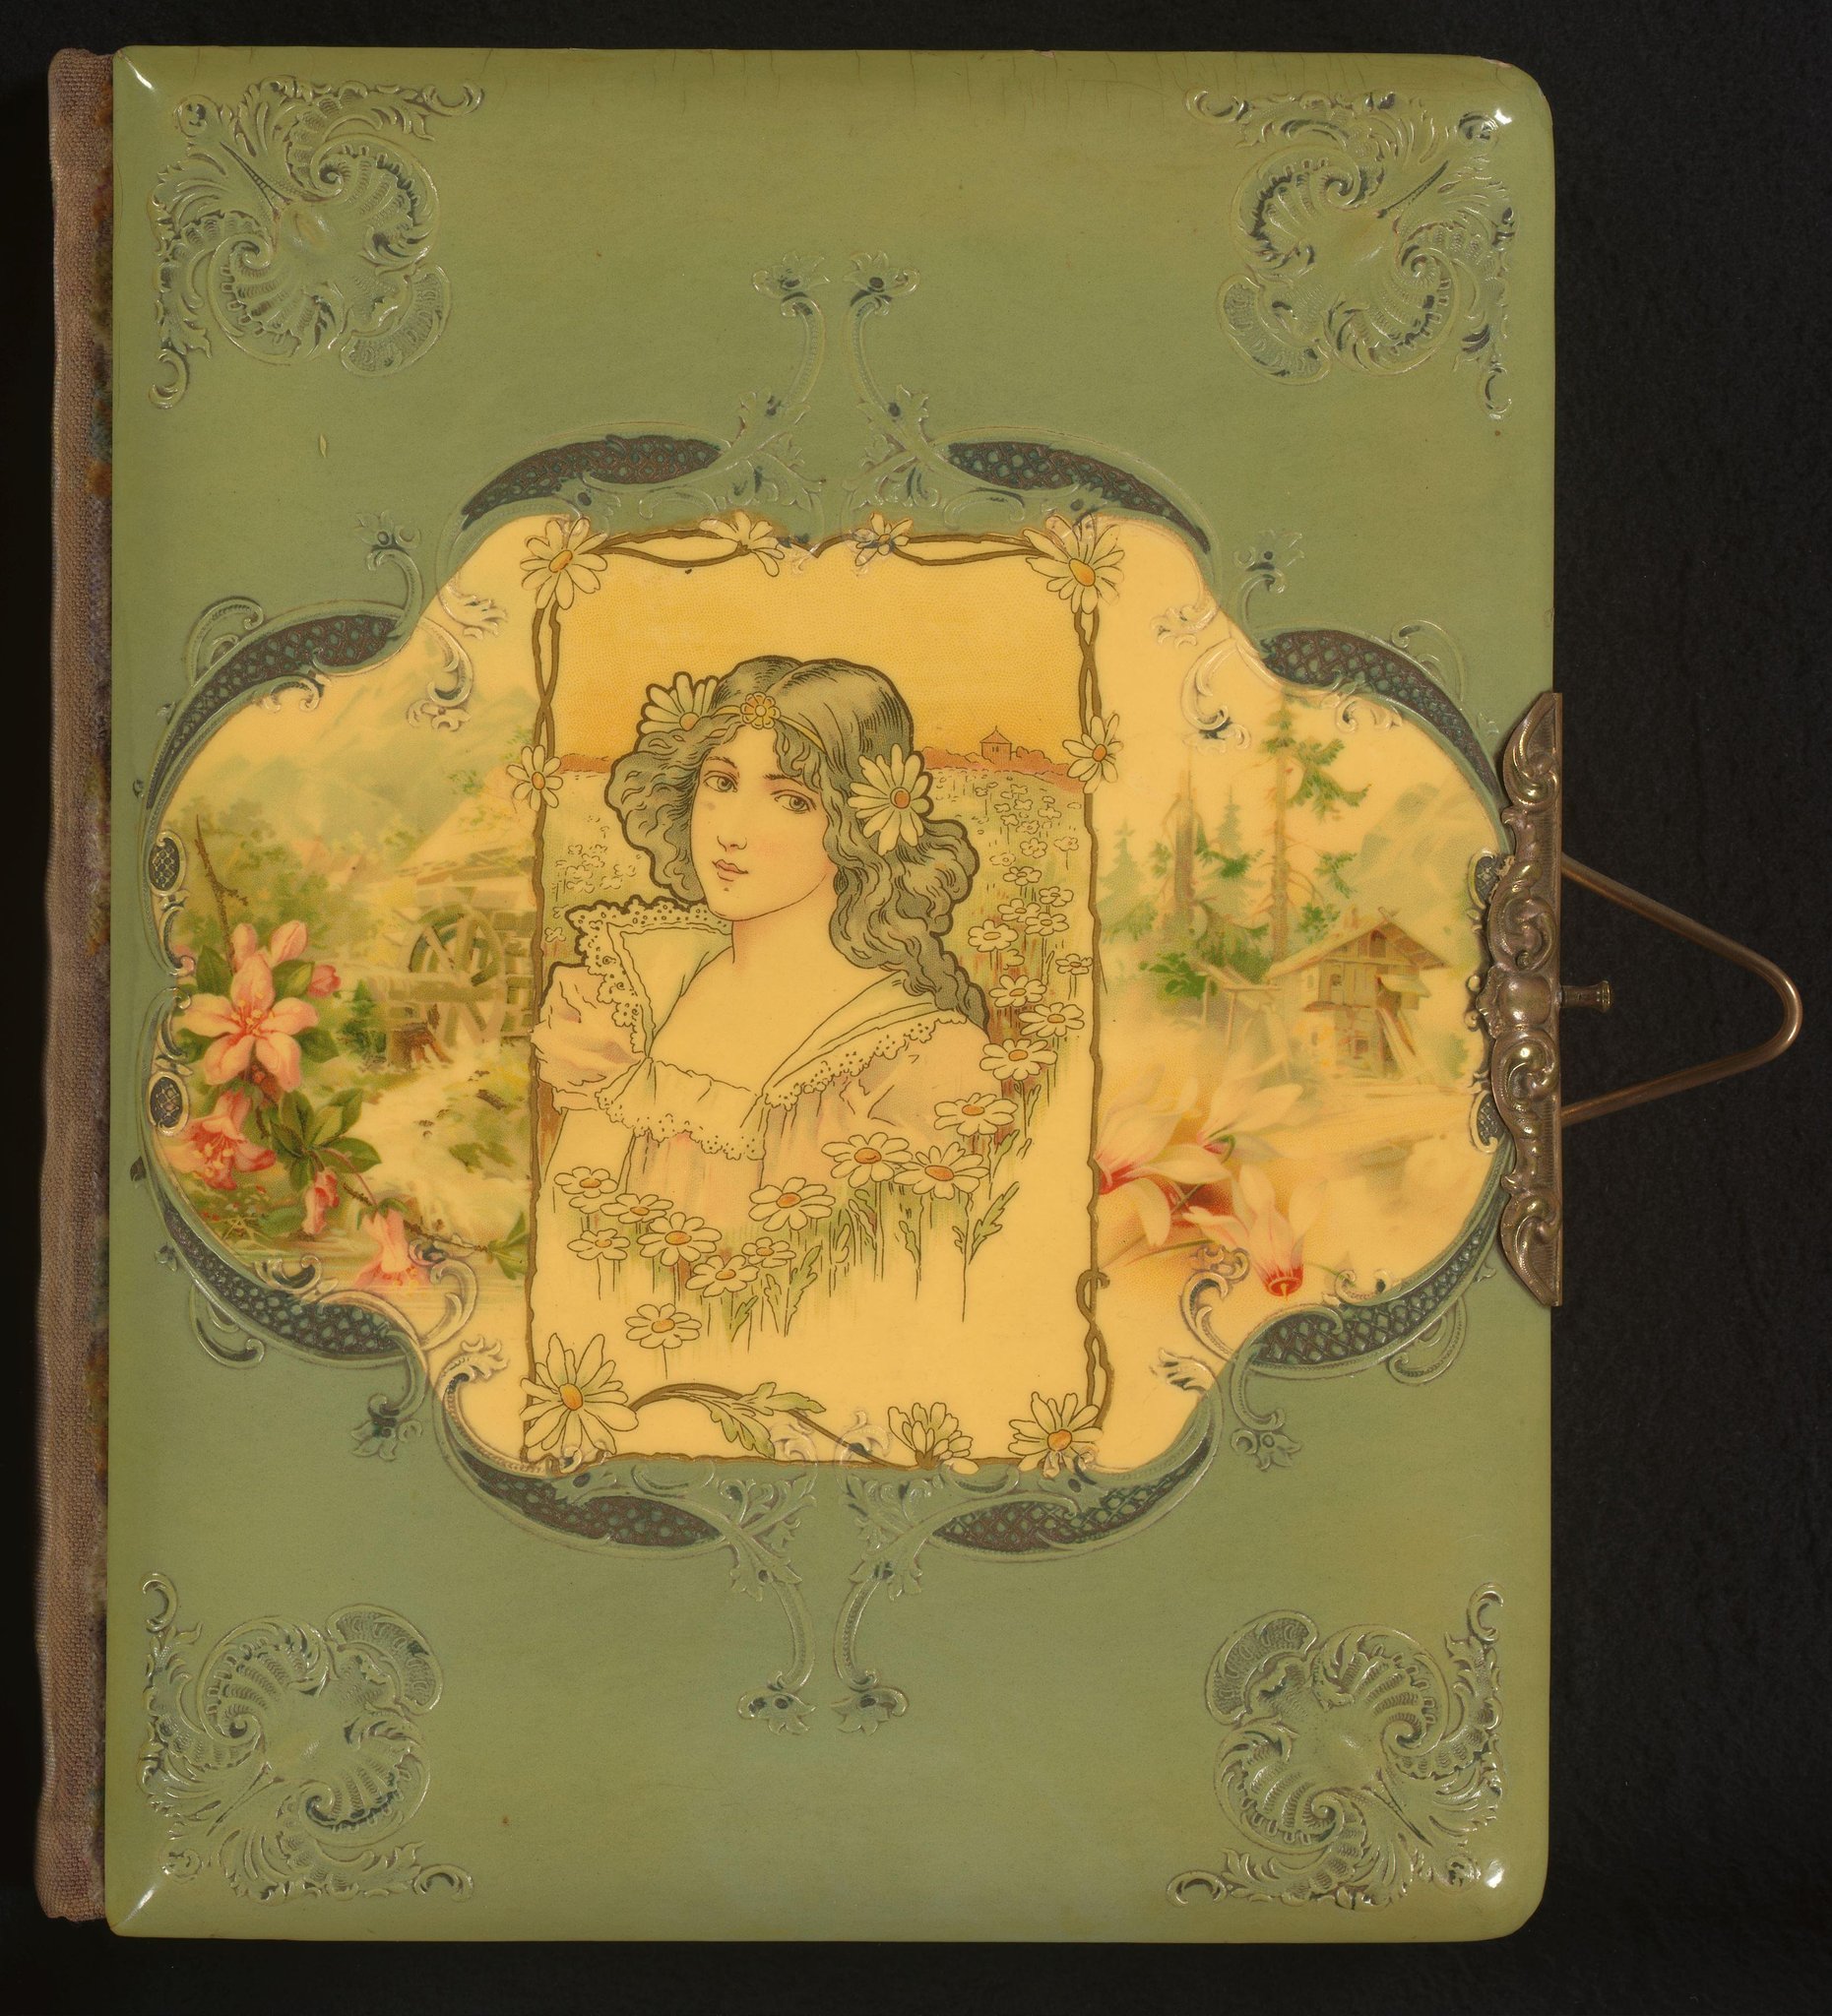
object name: photograph album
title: Fotoalbum (leeg)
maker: Anonymous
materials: cardboard, lacquer, metal, paper, textile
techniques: lithograph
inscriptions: annotation: ‘met gedraaid ijzeren/ standaard/ (Broos, WPL, 71/2 F10,-)’, collector's mark: ‘DIENST/ VERSPREIDE/ RIJKSKOLLEKTIES/ (...) A 721’, annotation: ‘Erinding fra Dagmar/ Til Frida/ Julen 1902’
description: Fotoalbum met 24 pagina's met ofwel een met gouden lijnen omkaderde passe-partout voor een kabinetfoto, ofwel 4 met gouden lijnen omkaderde passe-partouts voor cartes-de-visite. Iedere pagina met passe-partout voor een kabinetfoto is gedecoreerd met bloemen in lithografie. In totaal is er in het album plaats voor 20 kabinetfoto's en 16 cartes-de-visite.